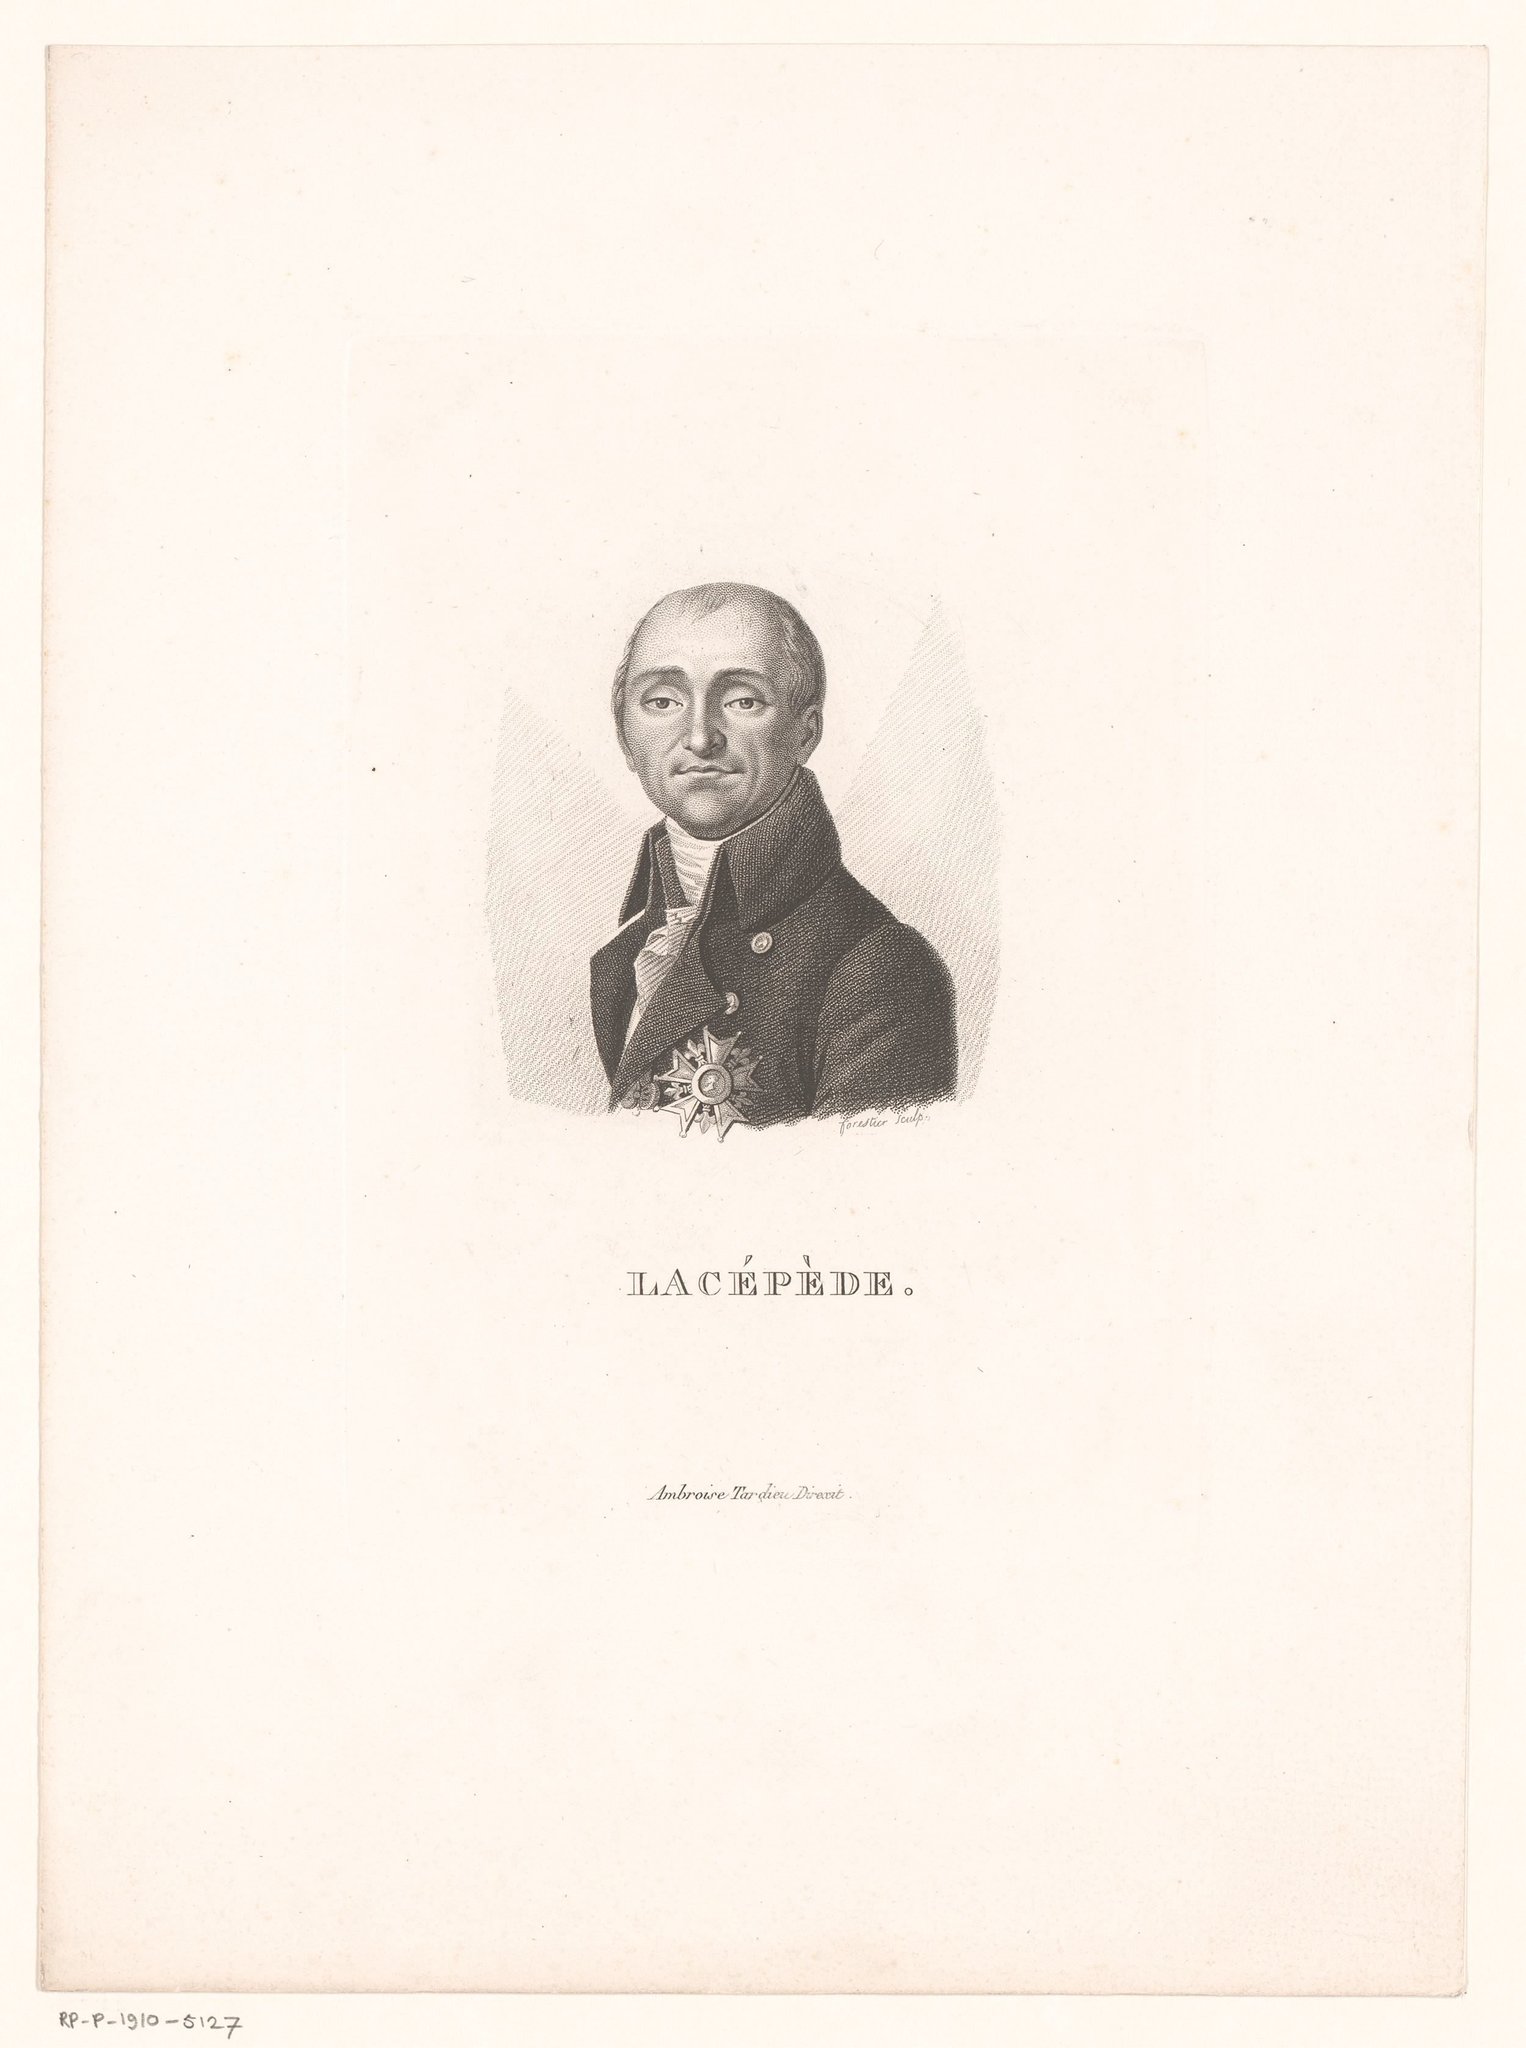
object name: print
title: Portret van Bernard Germain de Lacépède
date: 1799-1831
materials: paper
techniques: engraving, roulette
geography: france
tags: politician, scholar, philosopher, historical persons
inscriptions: collector's mark: Lugt 2228